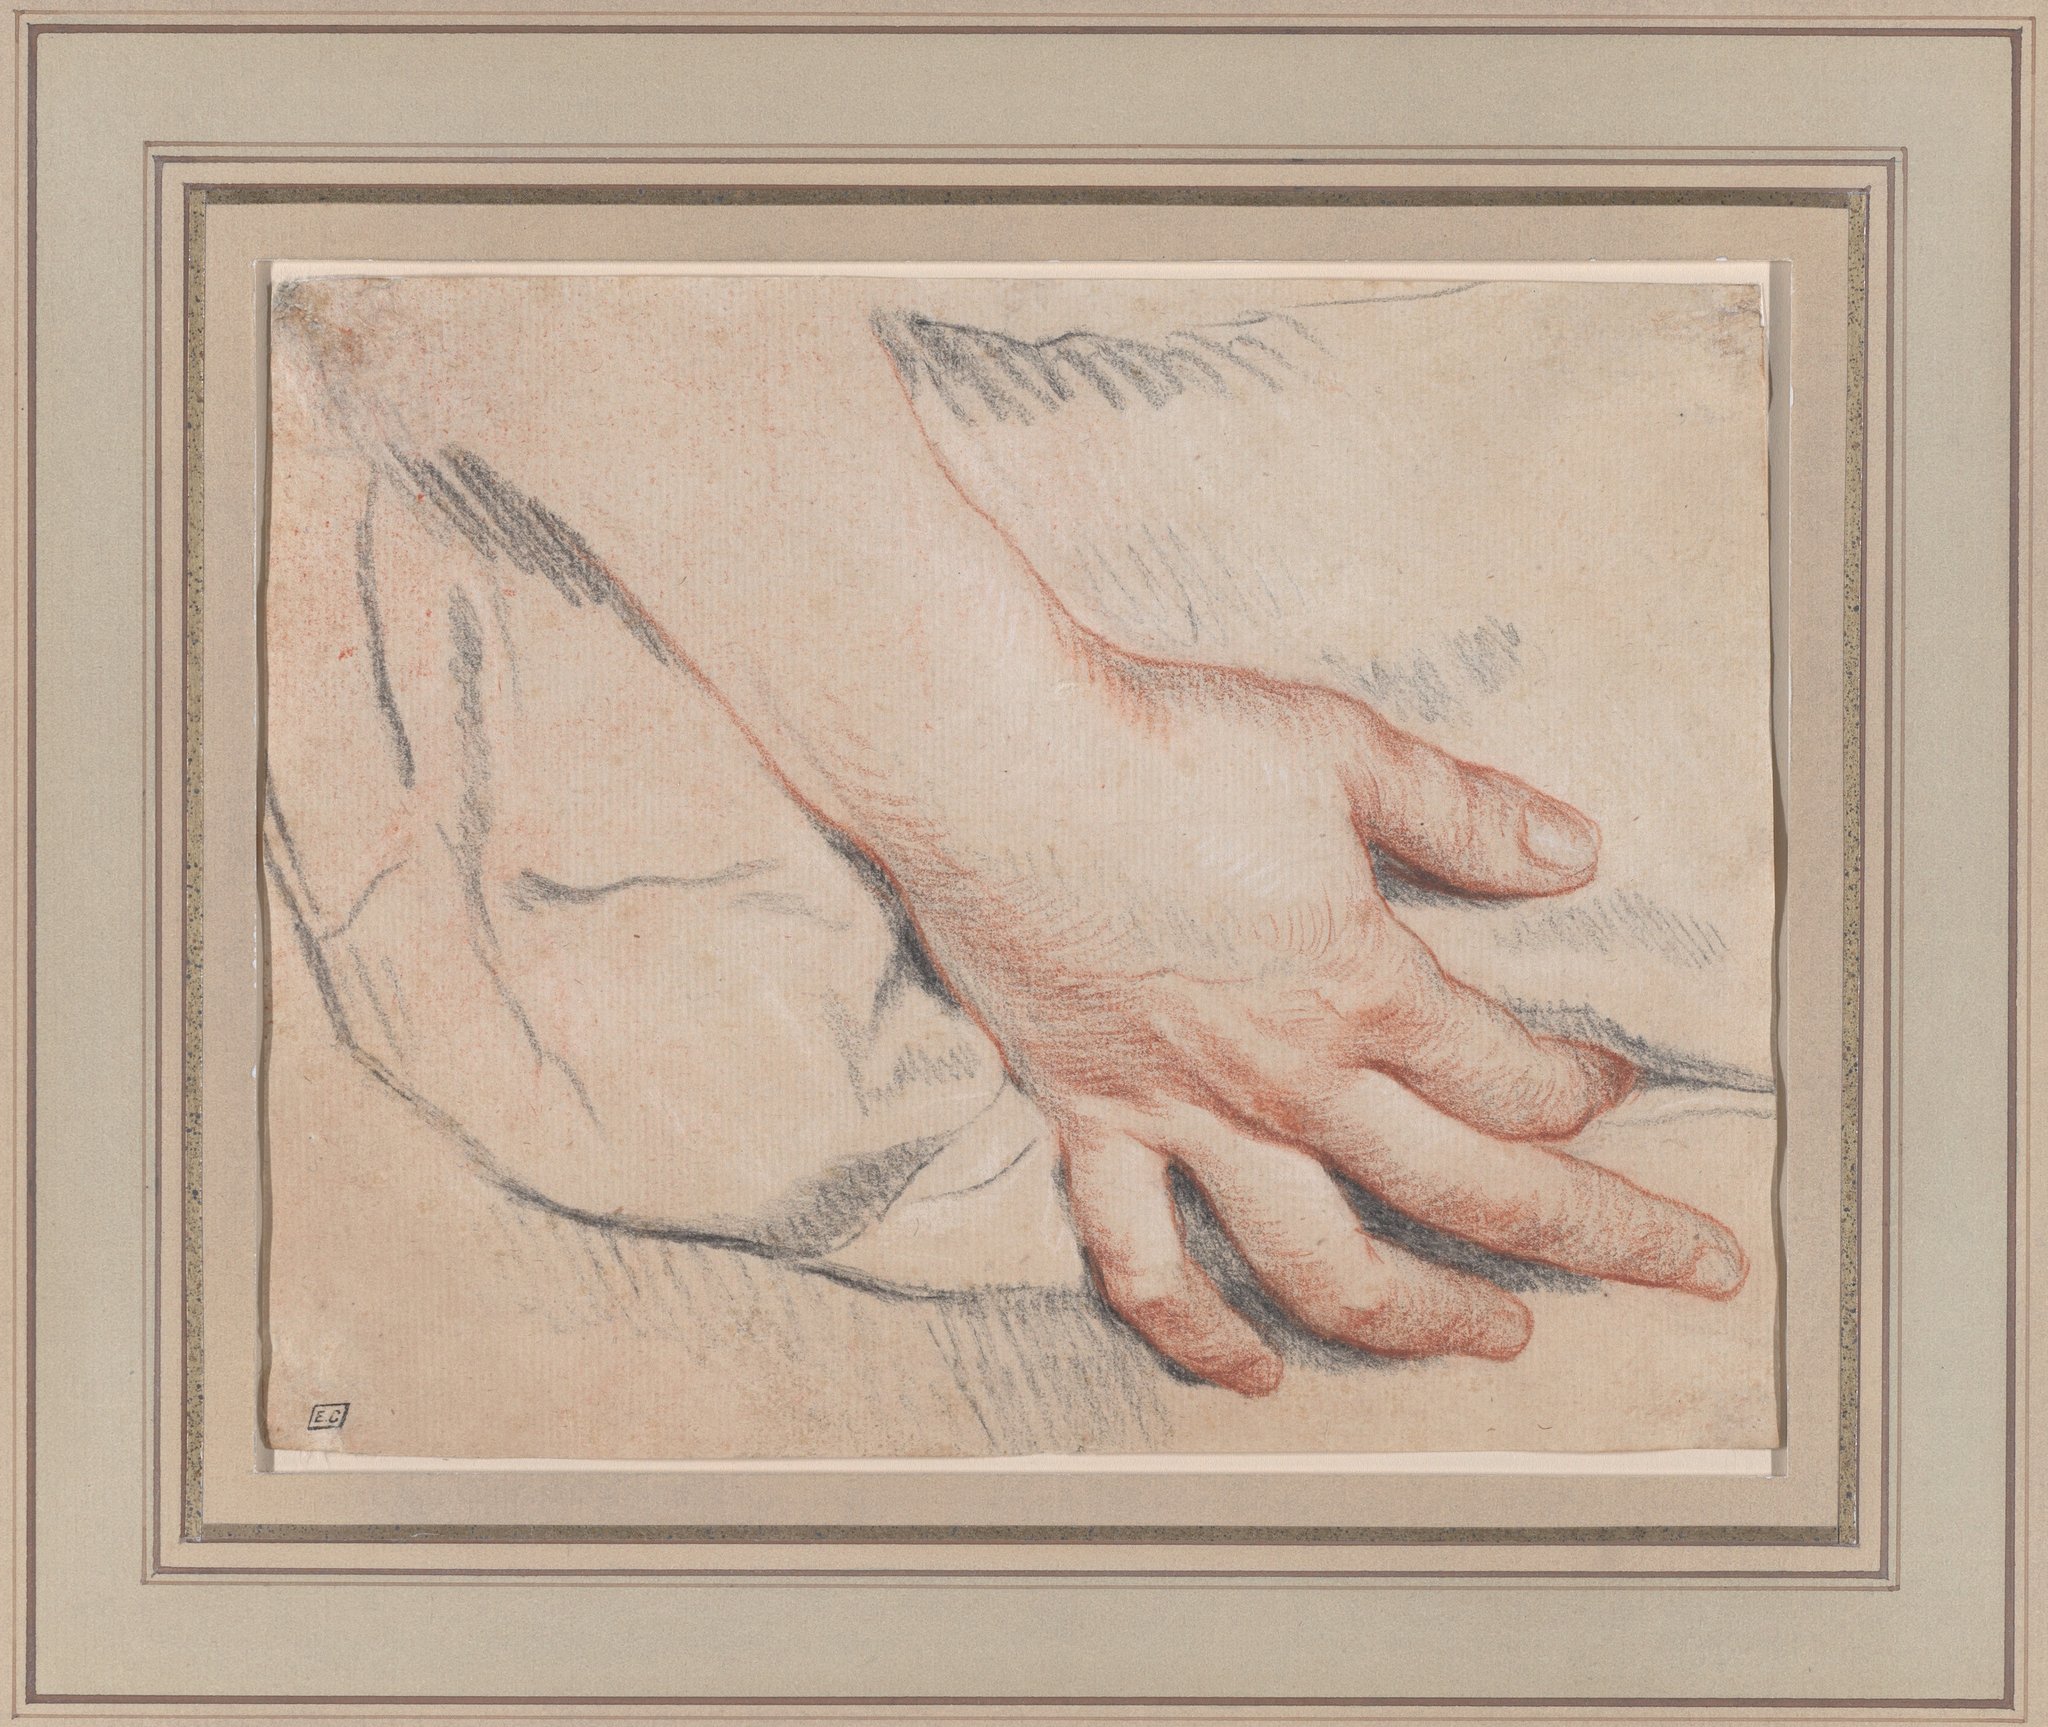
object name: drawing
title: Study of a Hand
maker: jean-baptiste greuze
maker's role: artist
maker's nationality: french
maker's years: 1725-1805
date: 1760-1780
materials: chalk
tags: hands